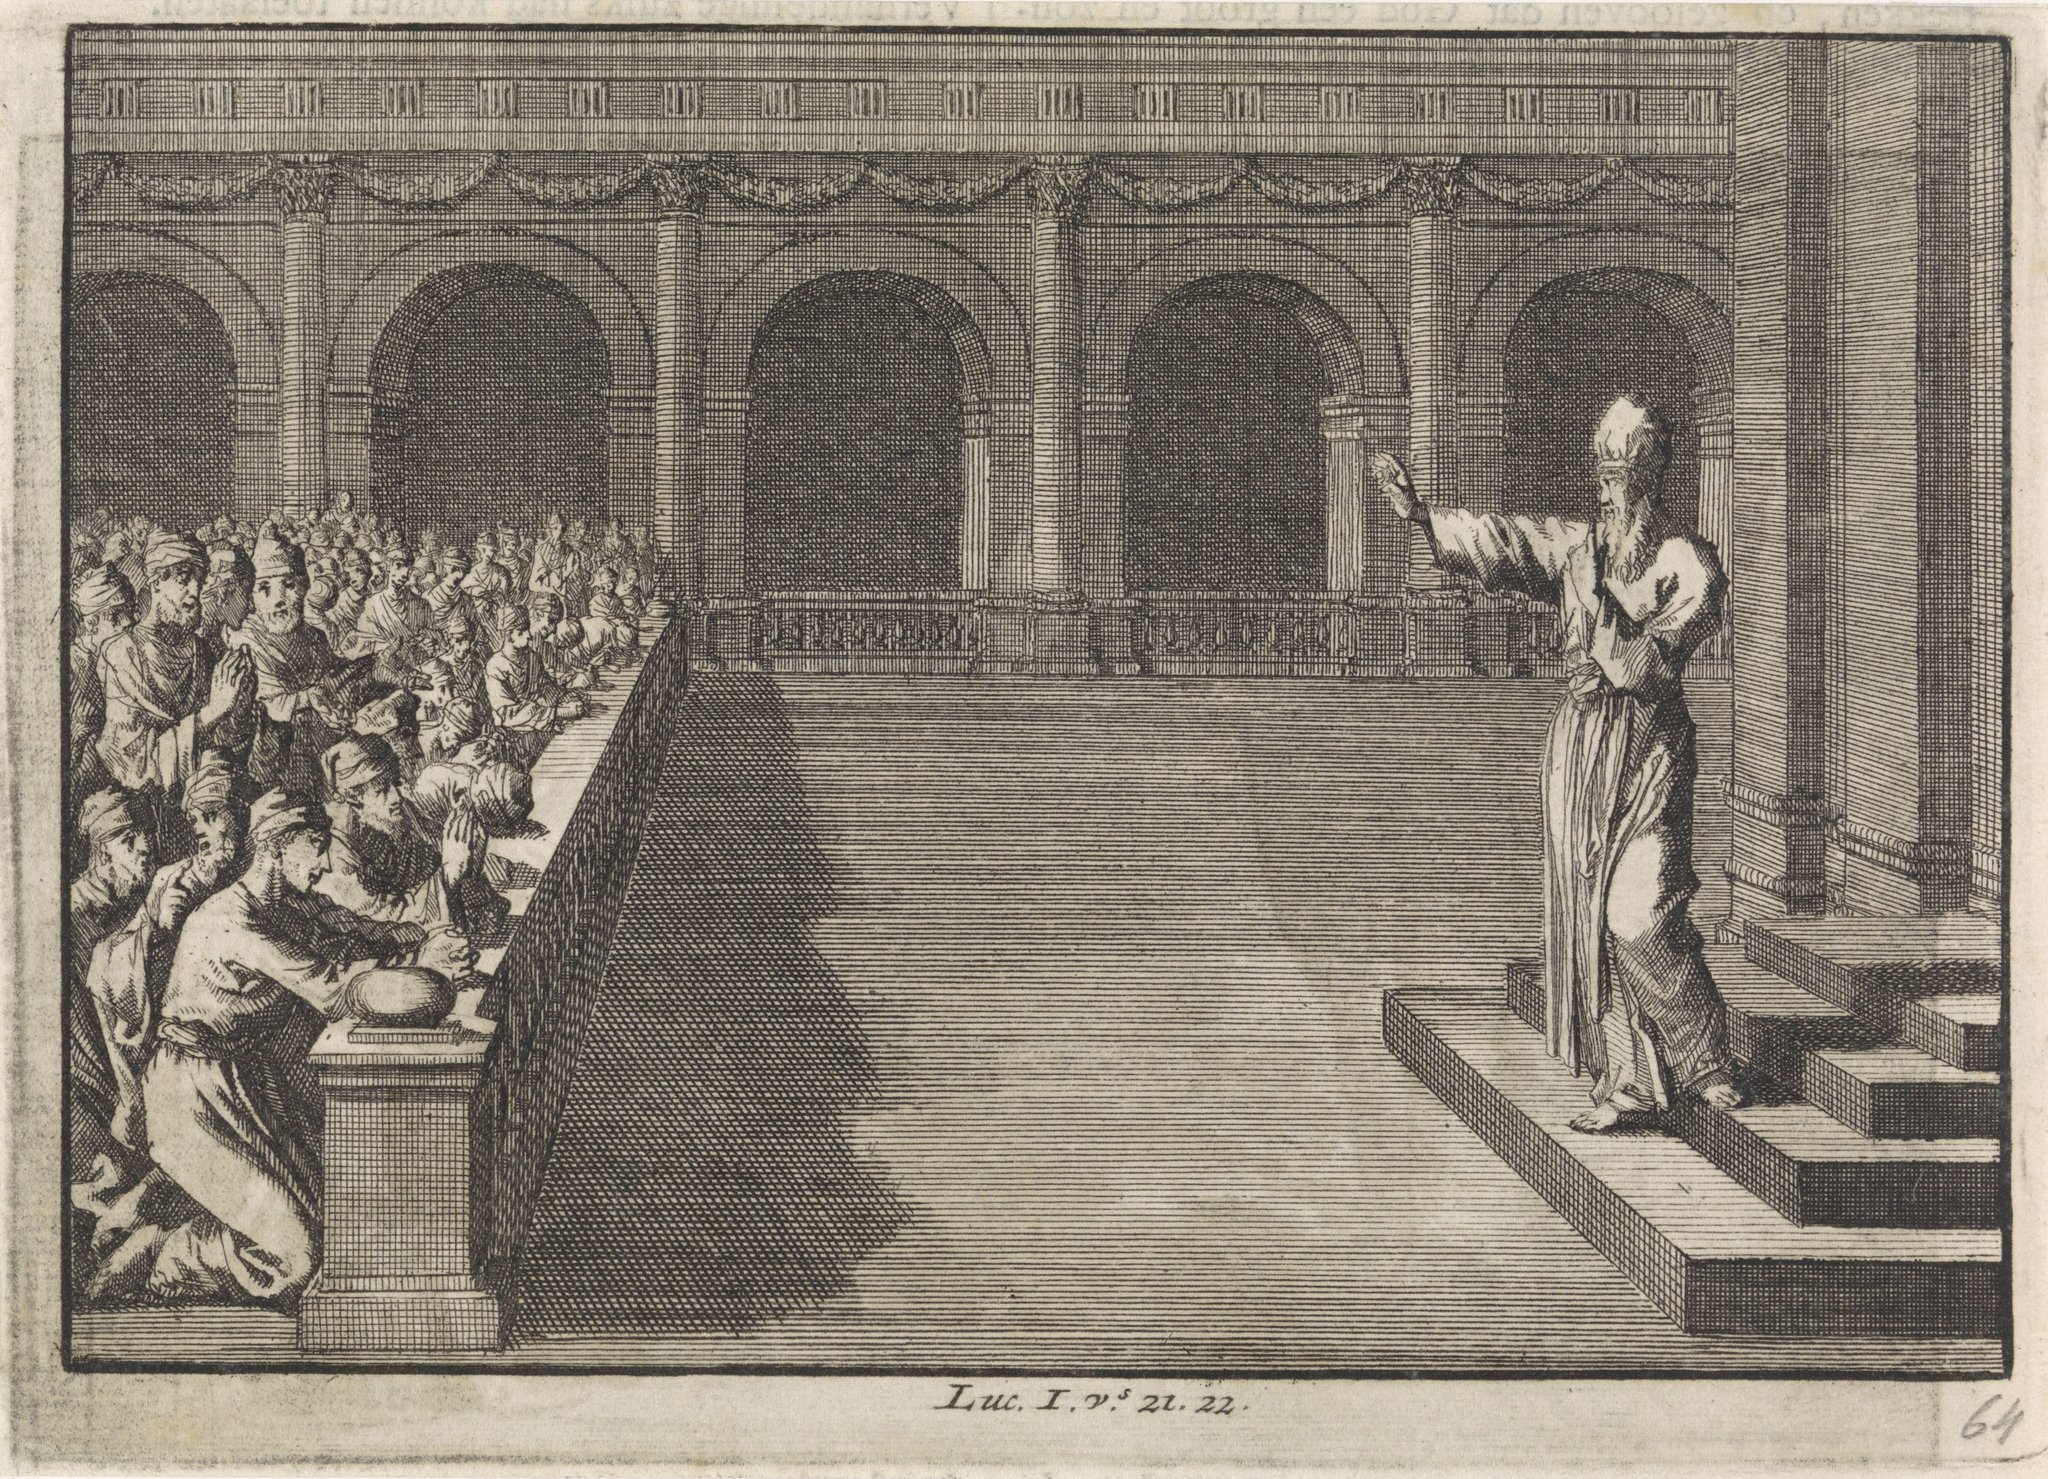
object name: book illustration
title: Zacharias tracht de menigte toe te spreken maar blijft stom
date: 1703-1762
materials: paper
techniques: etching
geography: amsterdam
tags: zacharias speechless before the people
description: De prent komt een eerste keer voor als boekillustratie voor David Martin. Historie des Ouden en Nieuwen Testaments. Amsterdam, Pieter Mortier, 1703. Deel II. De boekillustraties voor de Mortierbijbel hebben verschillende staten en kopieën, waarbij de chronologische volgorde moeilijk te achterhalen valt. Als boekillustraties werden ze bovendien herhaaldelijk opnieuw gebruikt voor andere boekwerken.